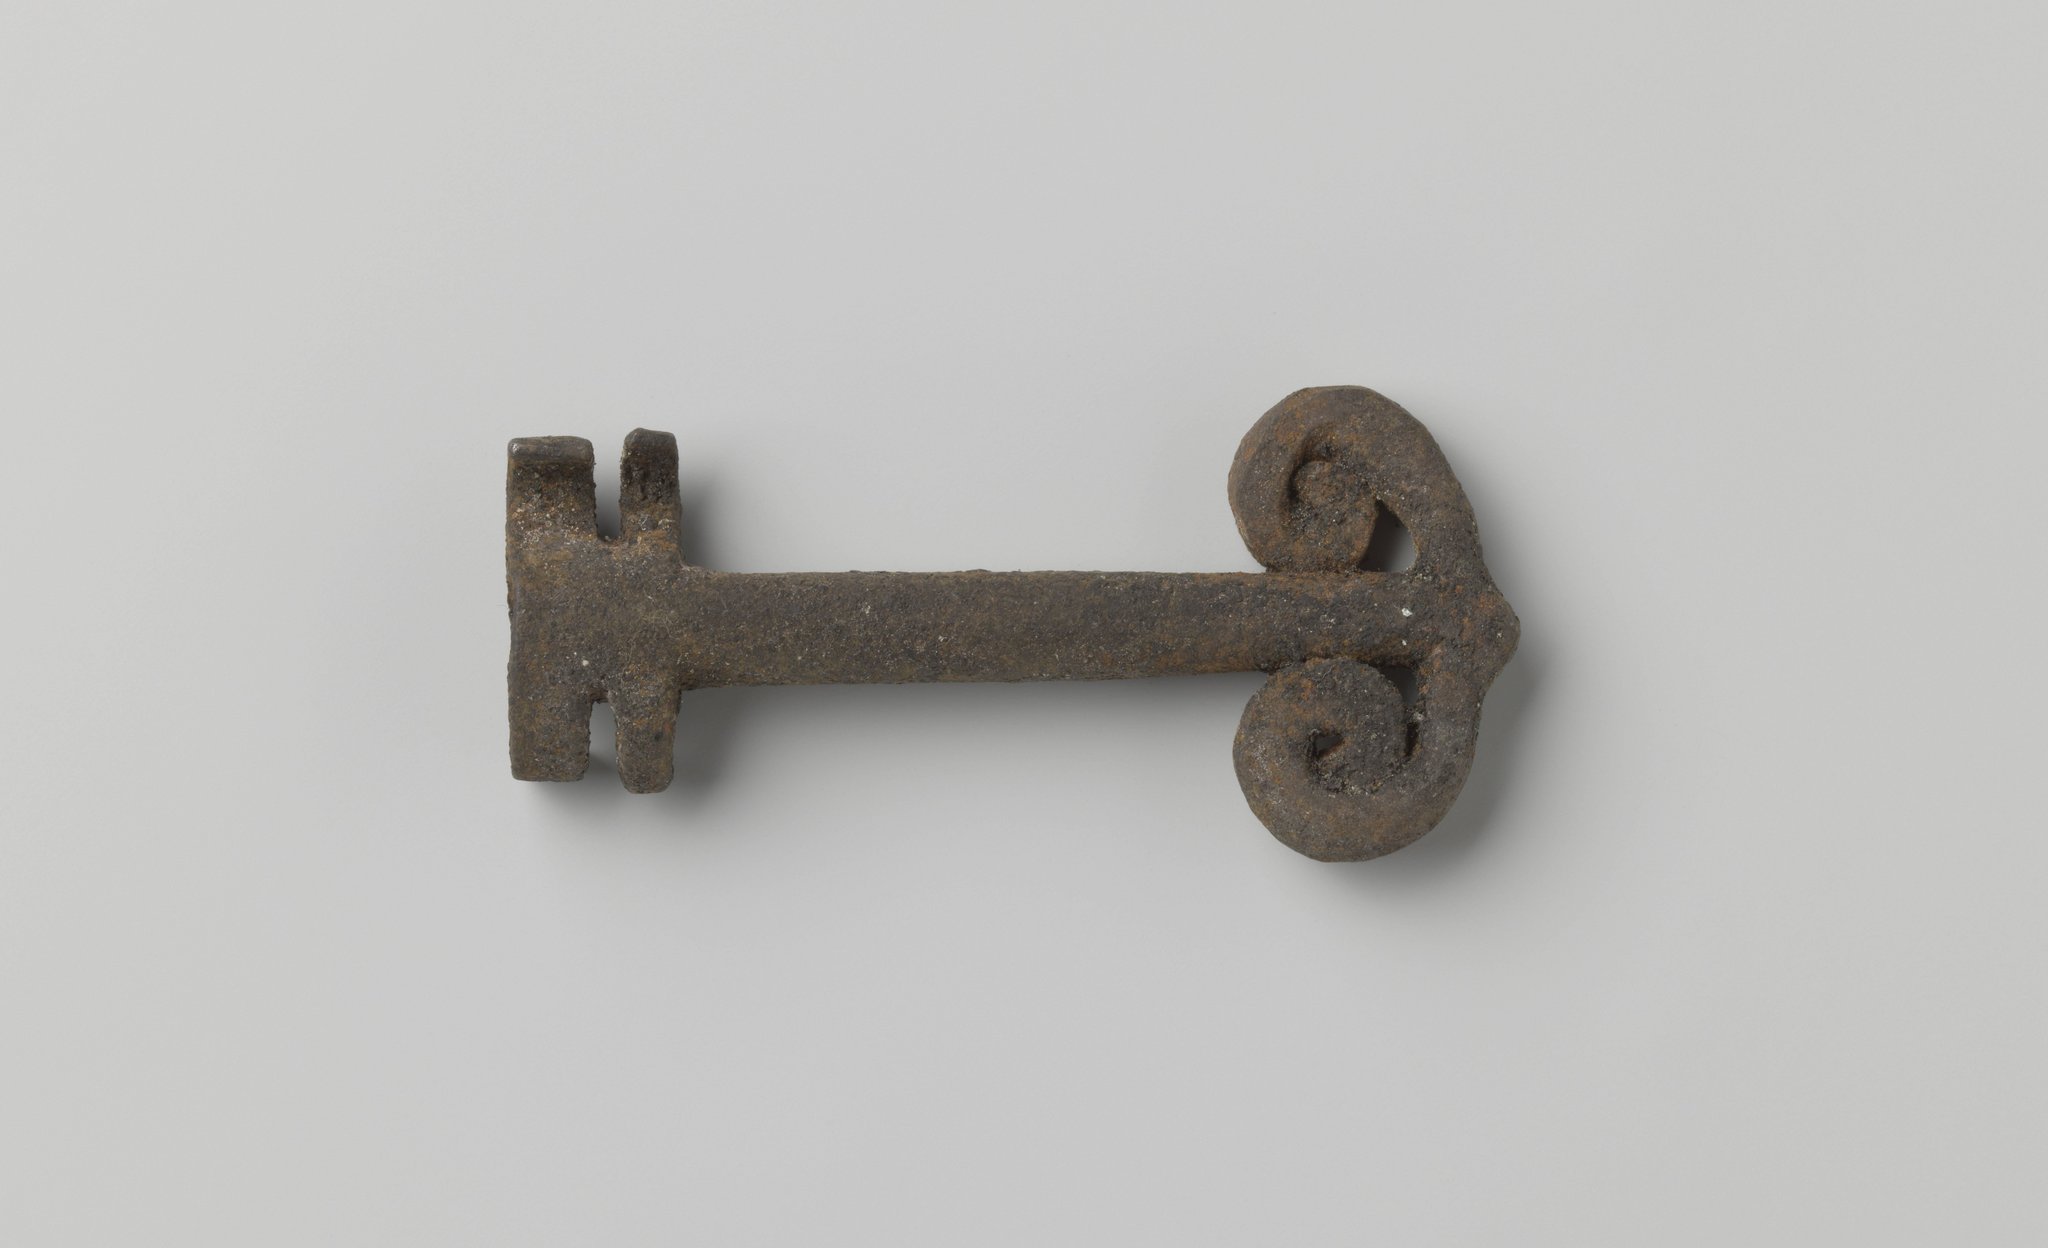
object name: pipe key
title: Pijpsleutel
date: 1600-1699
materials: iron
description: Pijpsleutel met dubbele haakvormige baard en greep bestaande uit twee naar binnen gebogen spiralen. Behorend bij een hangslot.